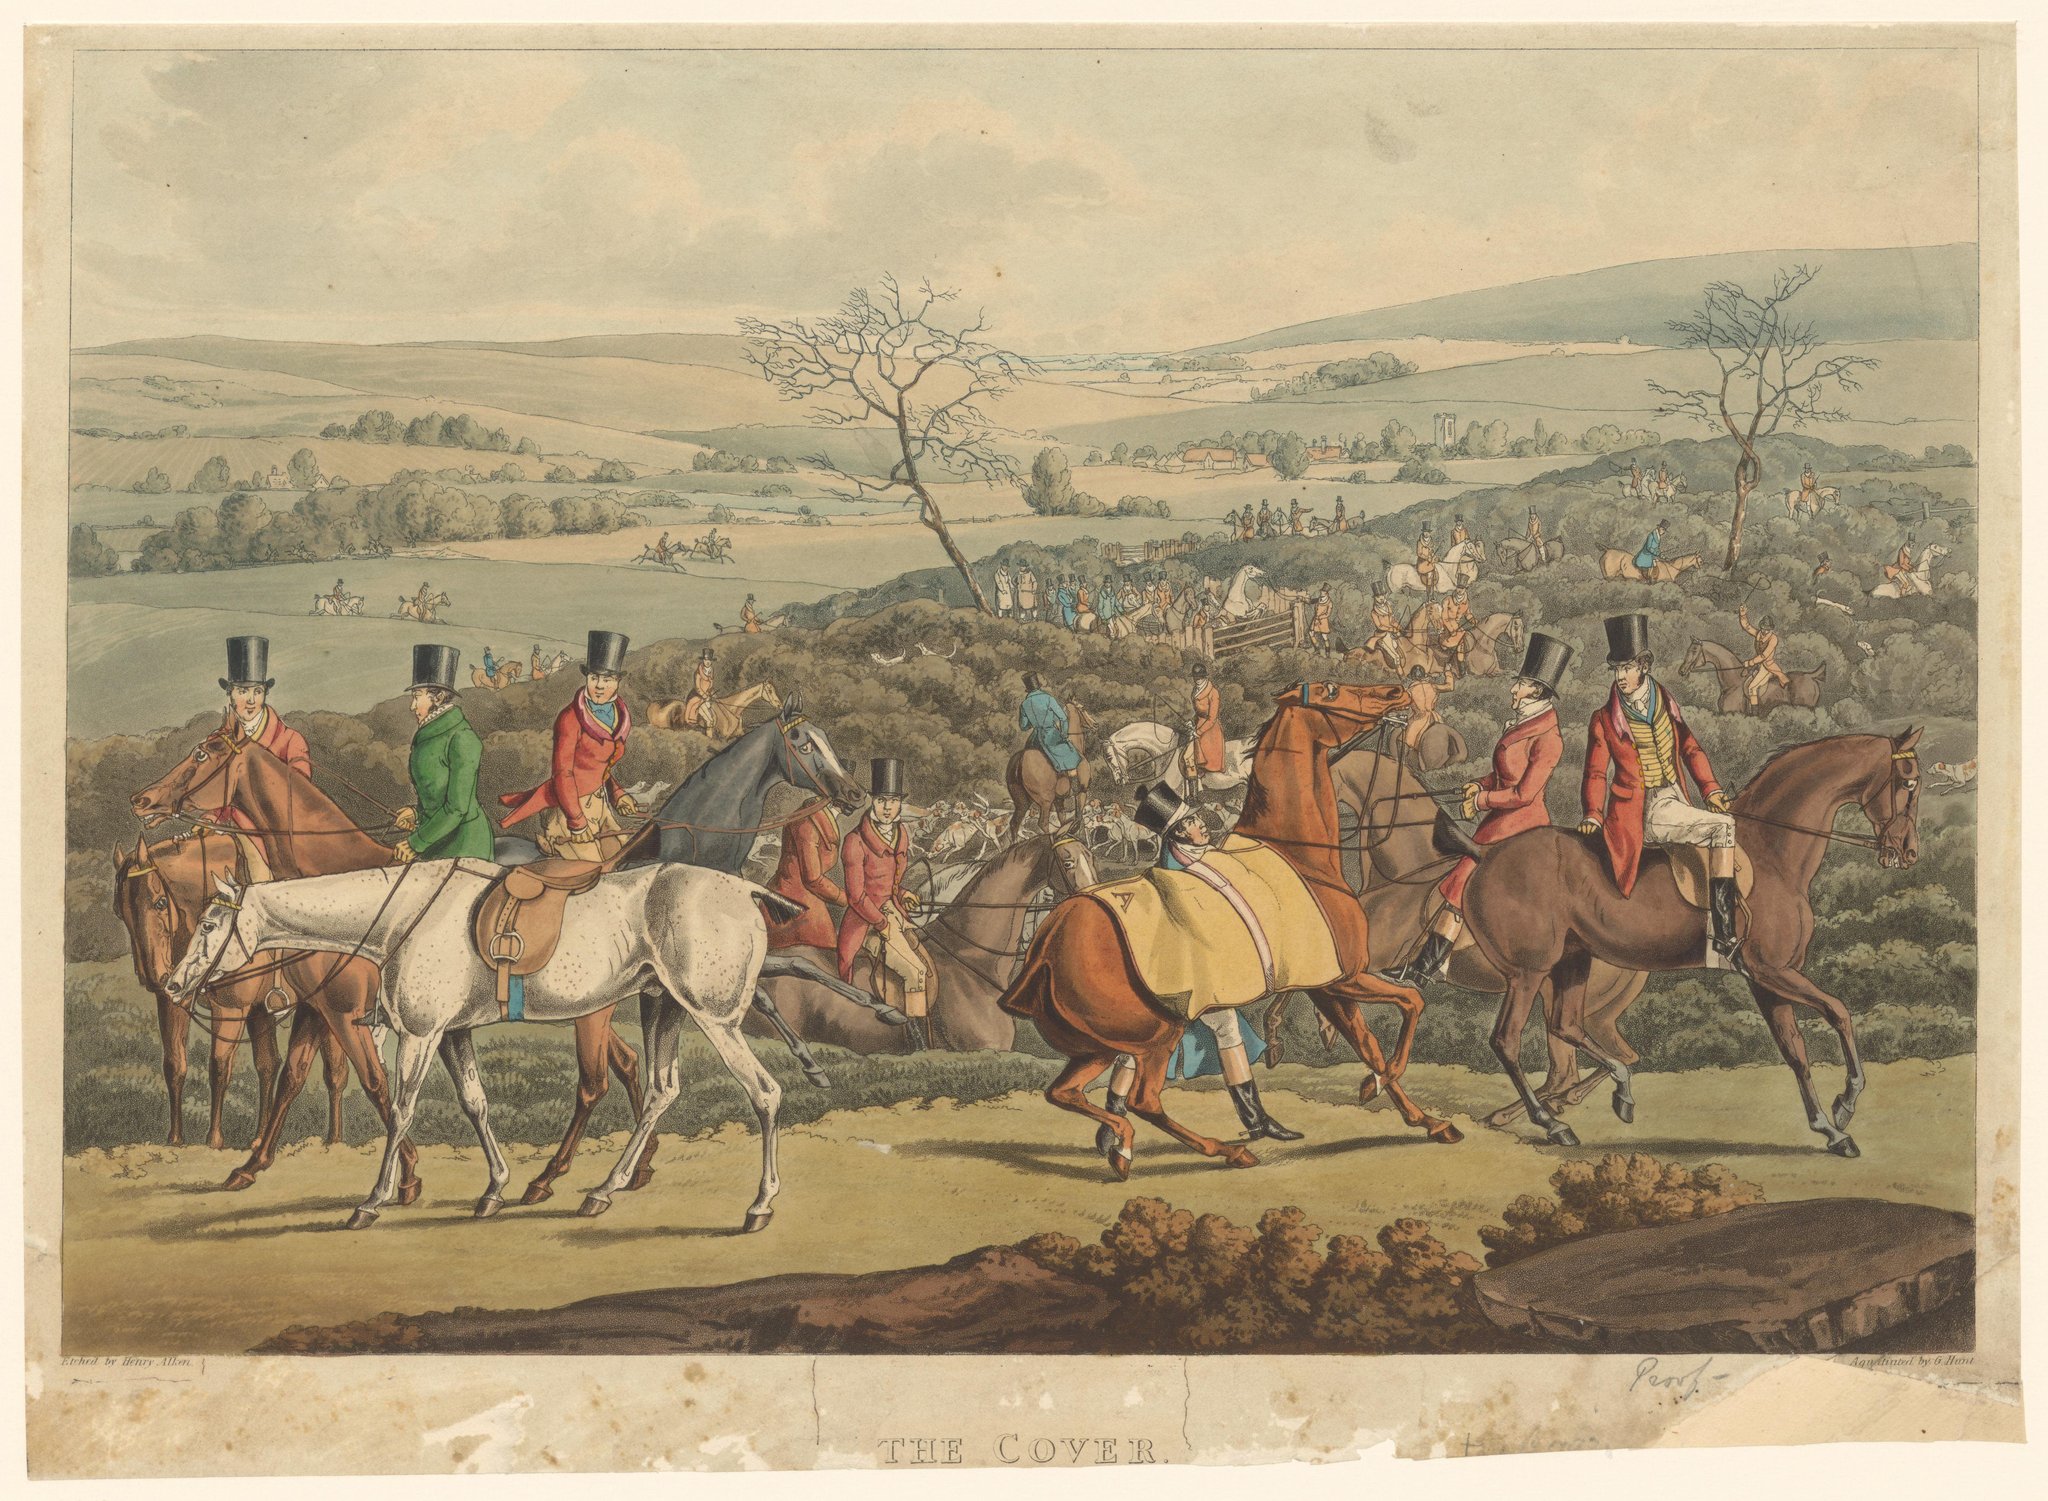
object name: print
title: Groep ruiters in een heuvelachtig landschap op jacht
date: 1815-1830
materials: paper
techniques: aquatint, etching, hand coloring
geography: london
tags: riding a horse, ass, or mule; rider, horseman, low hill country (+ landscape with figures, staffage), england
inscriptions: collector's mark: Lugt 2228